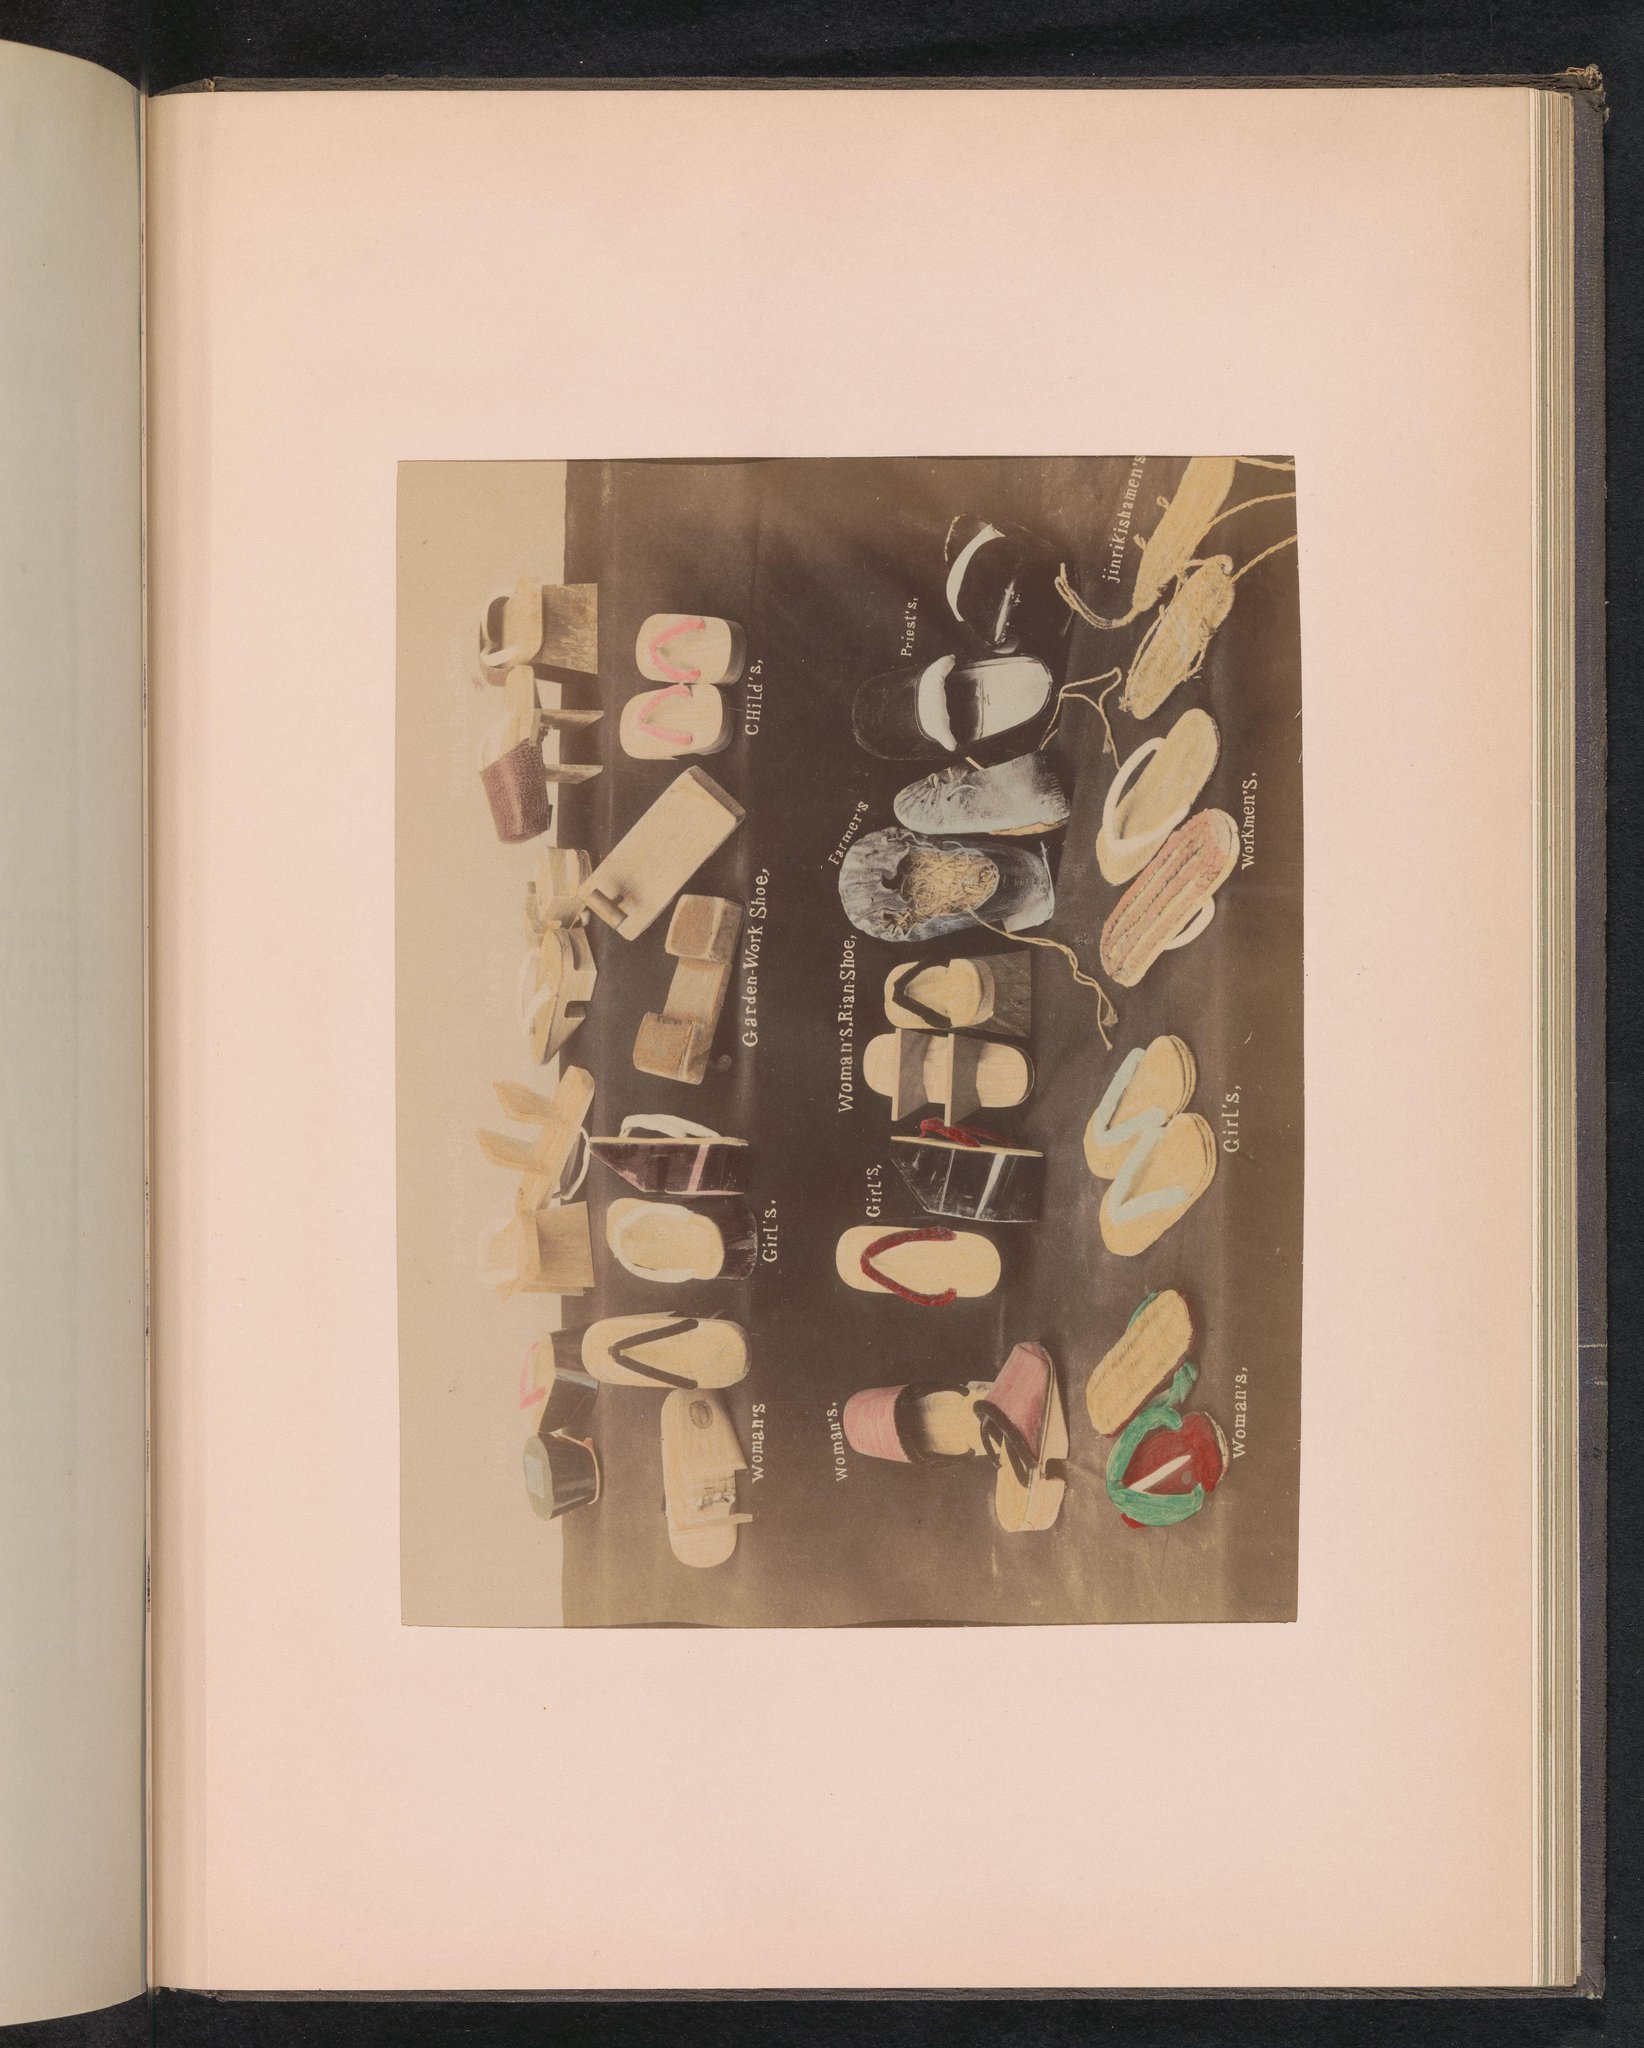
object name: photograph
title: Uitstalling van verschillende soorten Japanse schoenen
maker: Anonymous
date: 1887-1897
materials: photographic support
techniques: albumen print, hand coloring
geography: japan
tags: shoes, sandals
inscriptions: inscription